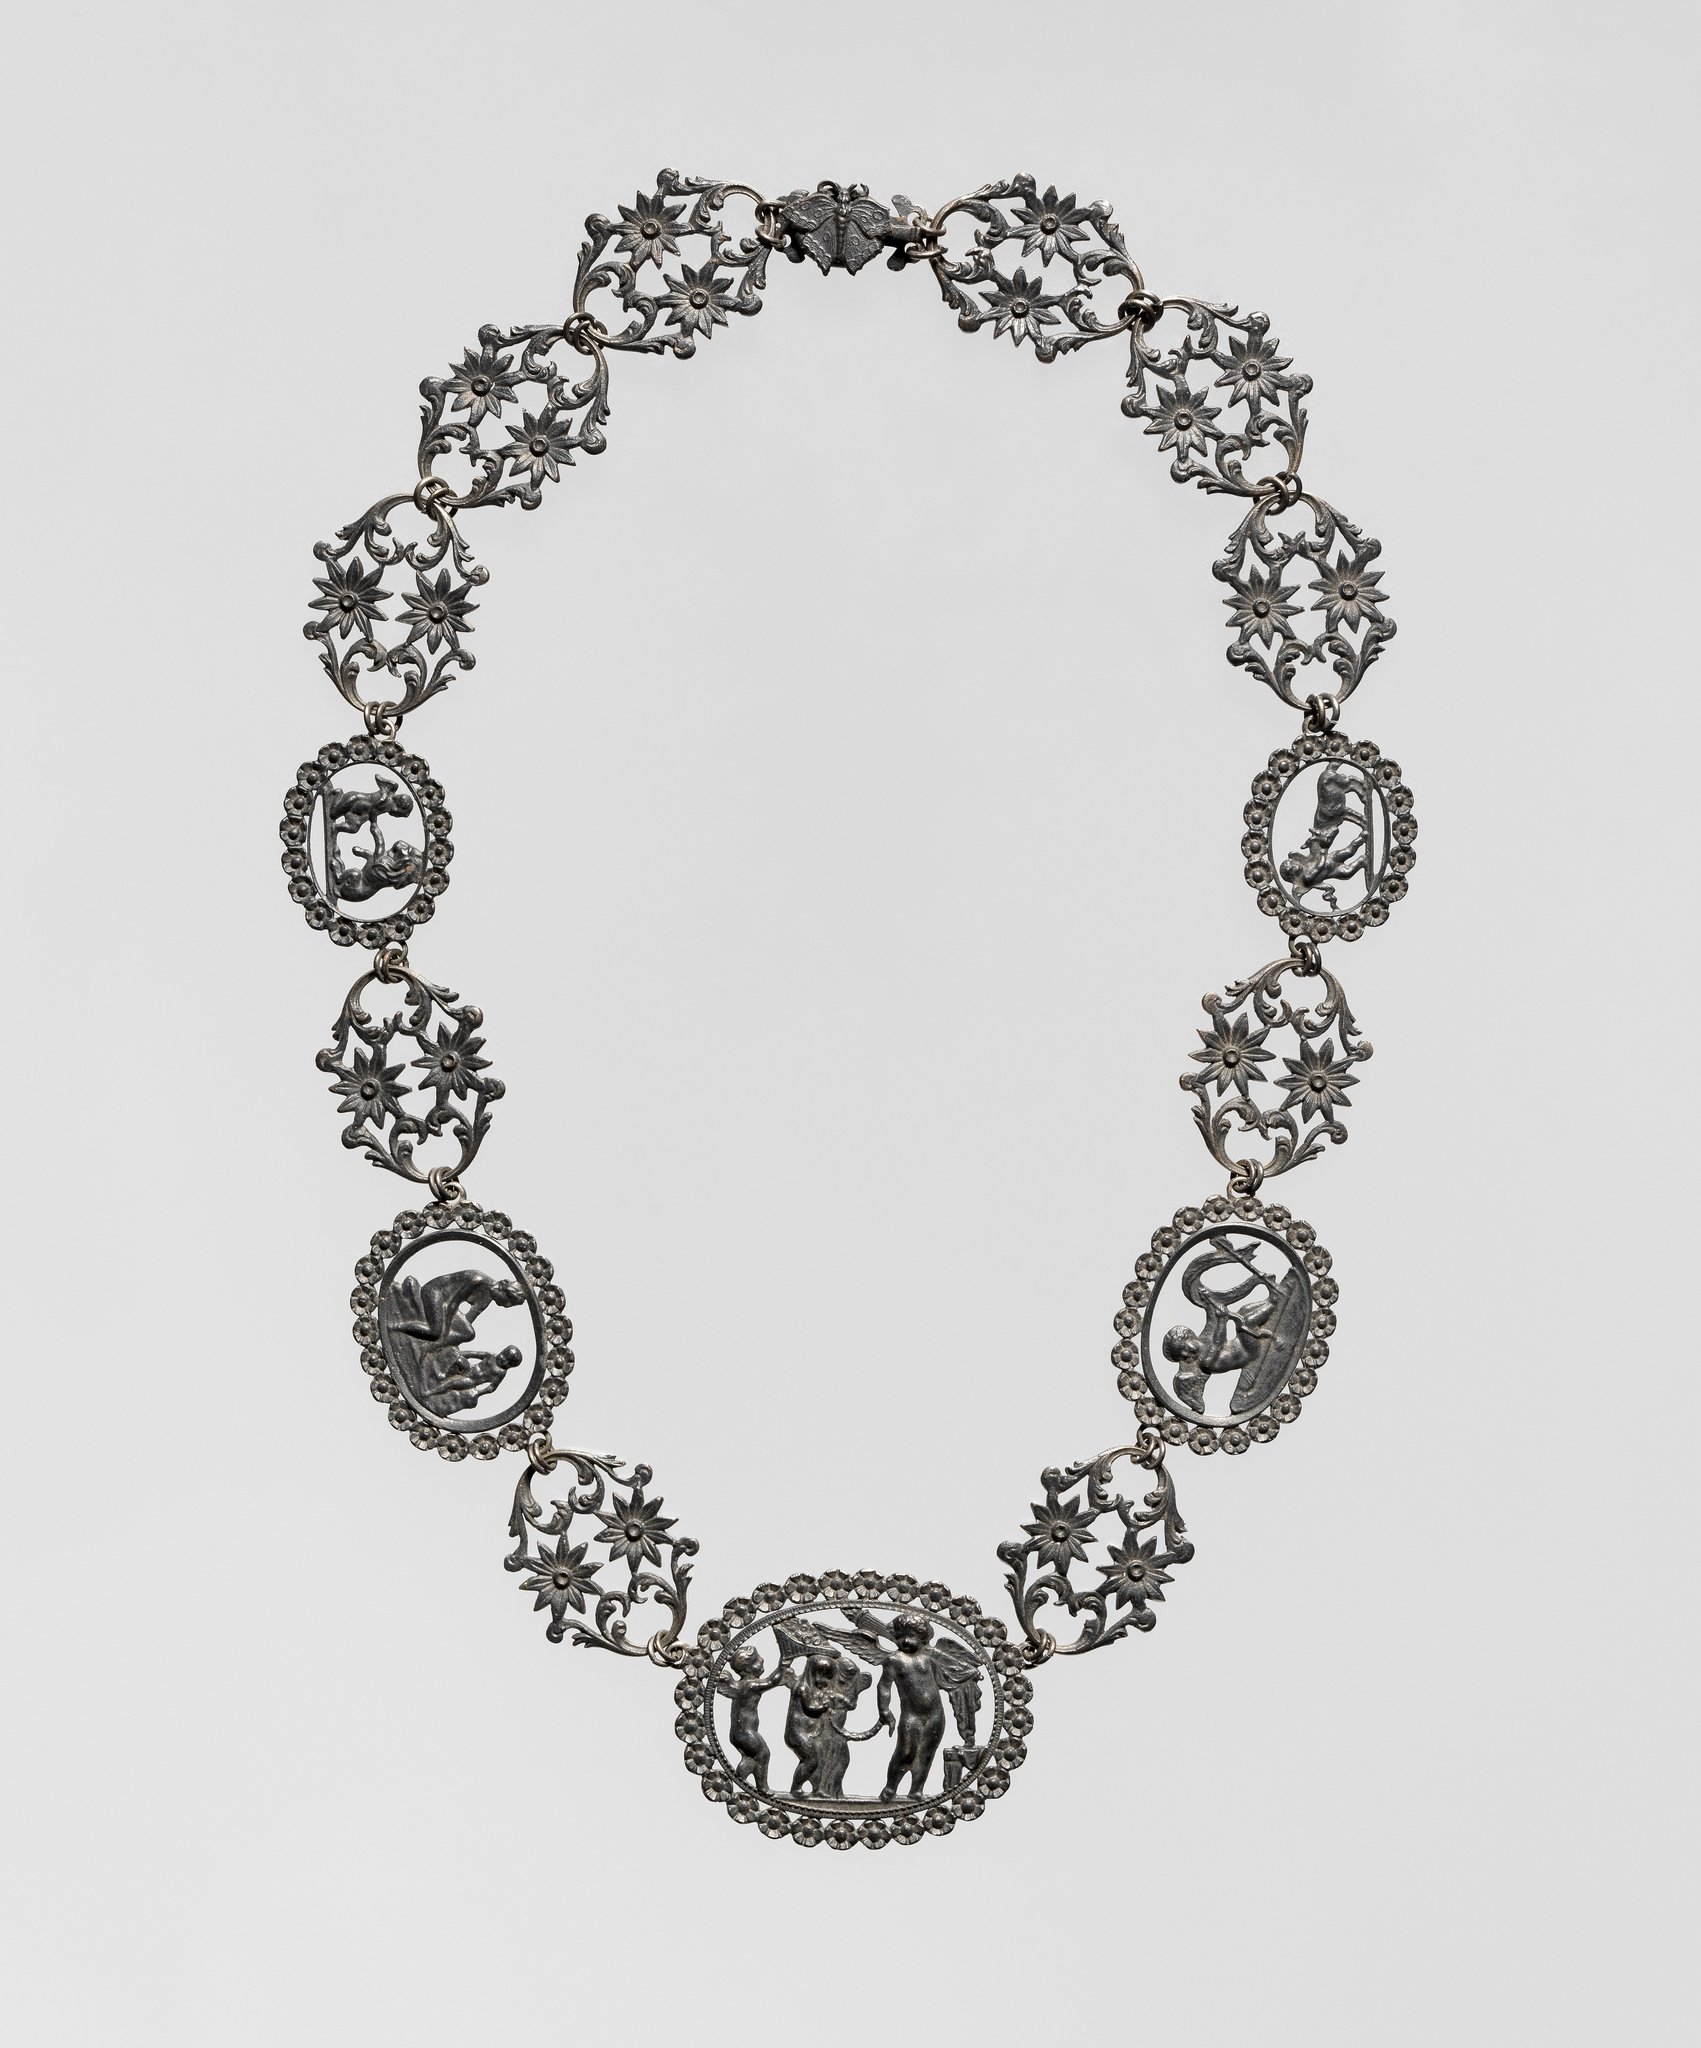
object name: necklace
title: Necklace (part of a set)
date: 1801-1833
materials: iron